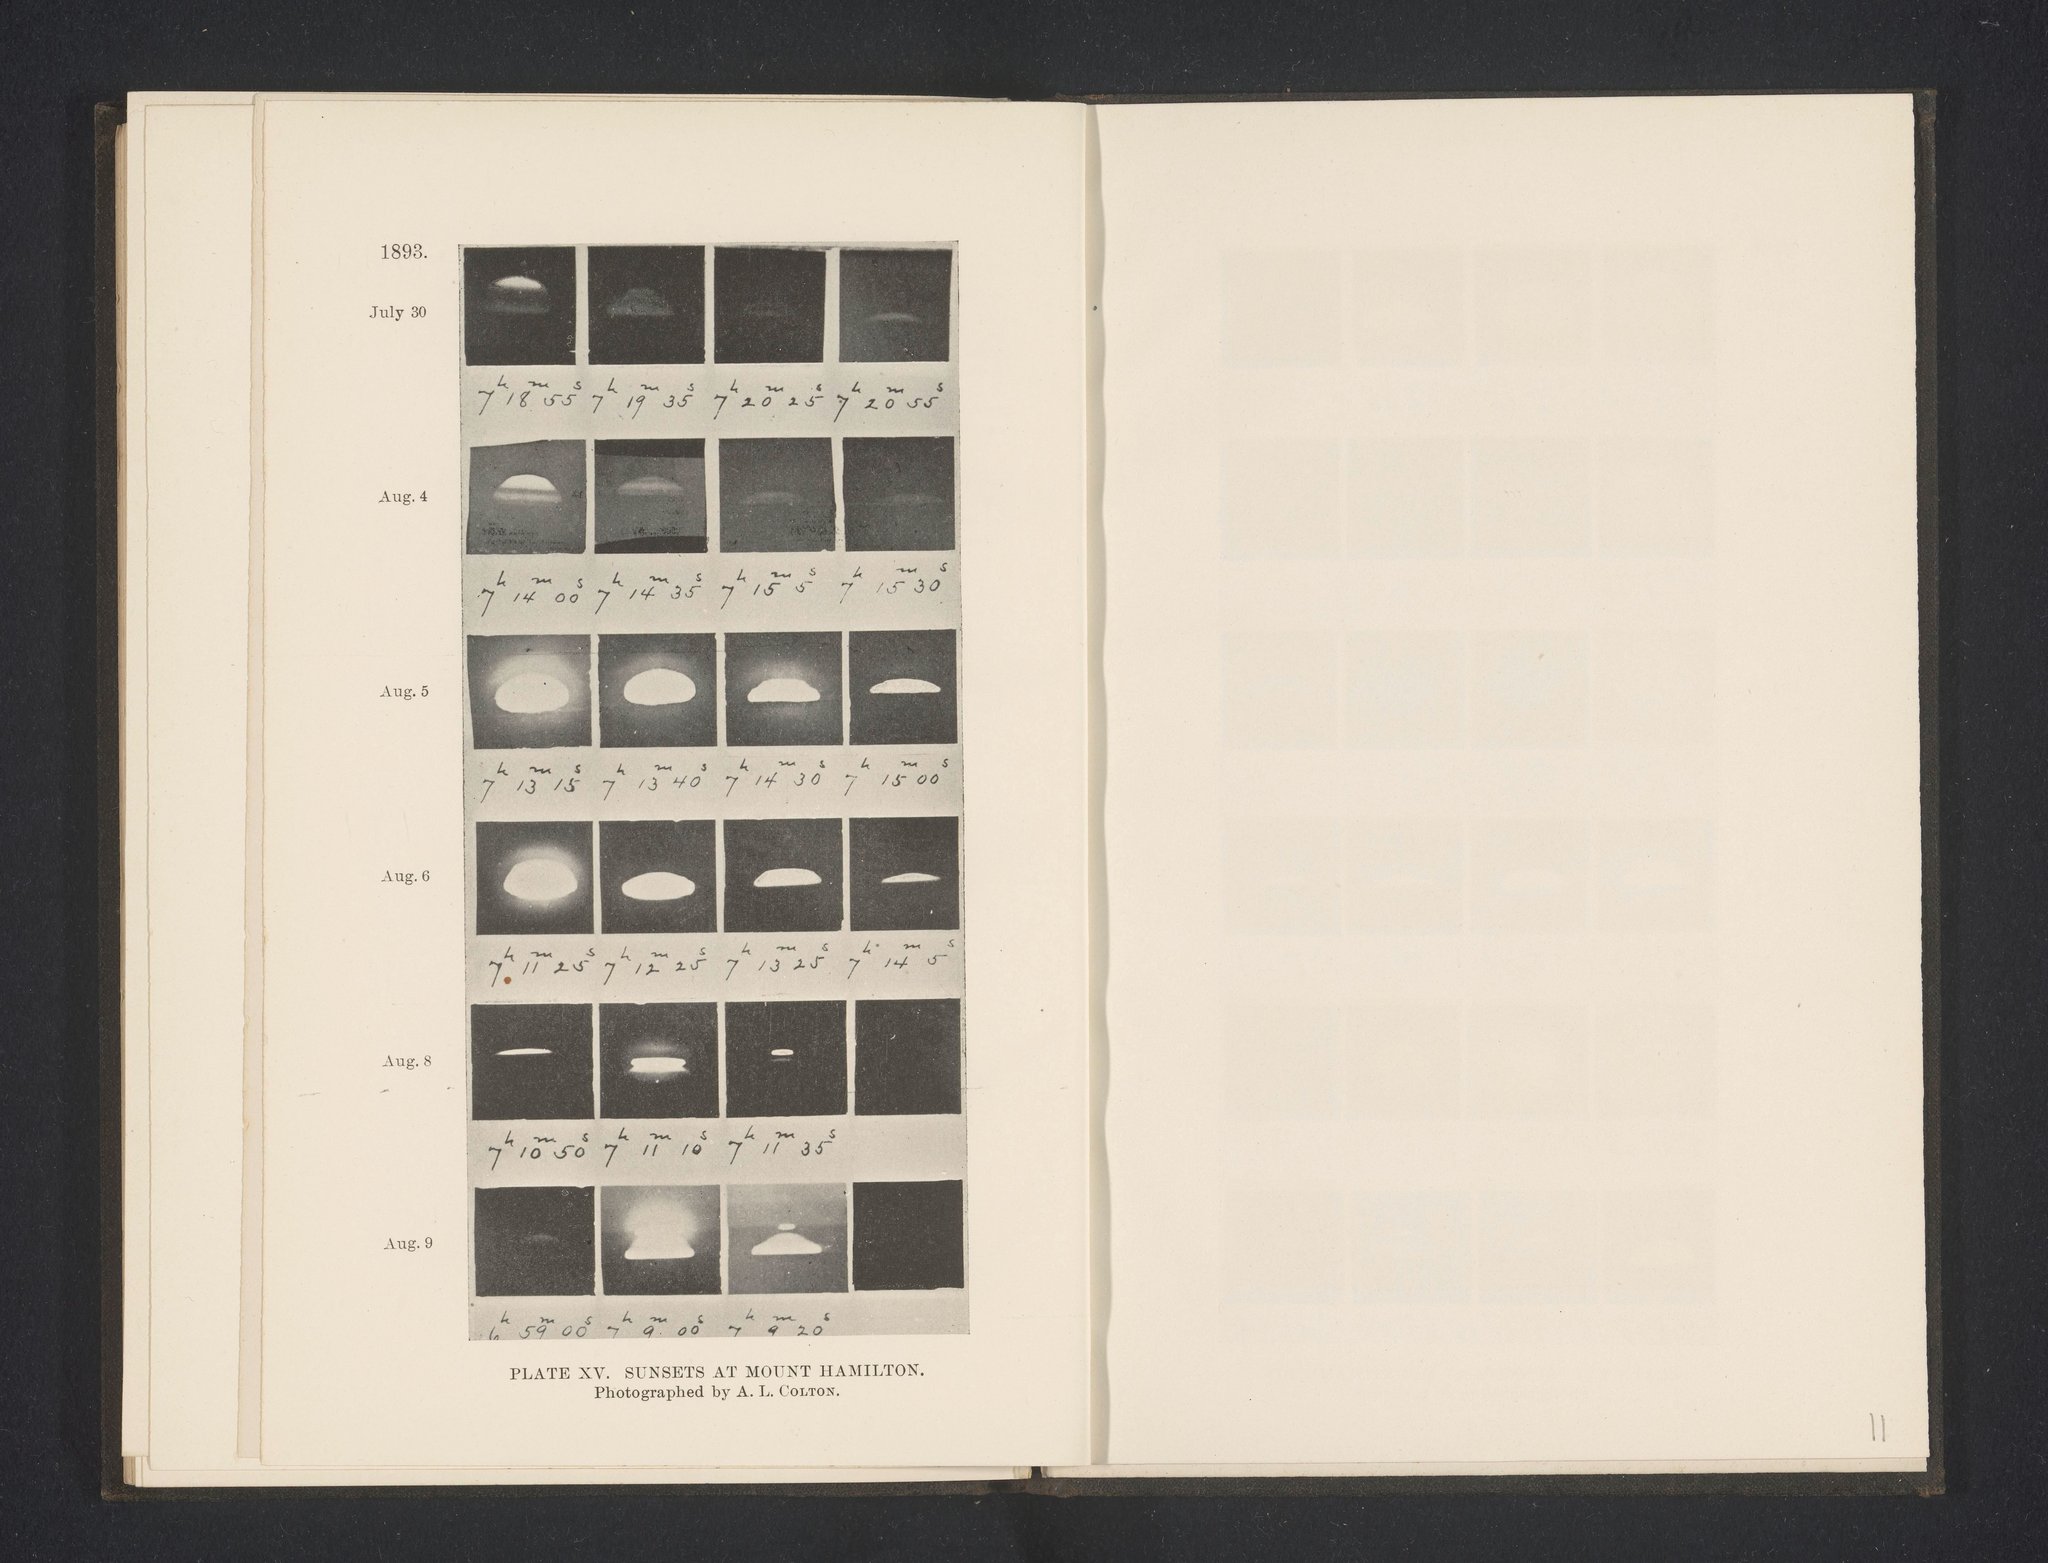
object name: photomechanical print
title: Plate XV. Sunsets at Mount Hamilton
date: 1893-1895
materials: paper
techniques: autotype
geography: lick observatory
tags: sunset, astronomy (and cosmography)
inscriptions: date: ‘1893/ July 30/ Aug. 4/ Aug. 5/ Aug. 6/ Aug. 8/ Aug. 9’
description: Prent op tweede ongenummerde pagina na pagina 86.